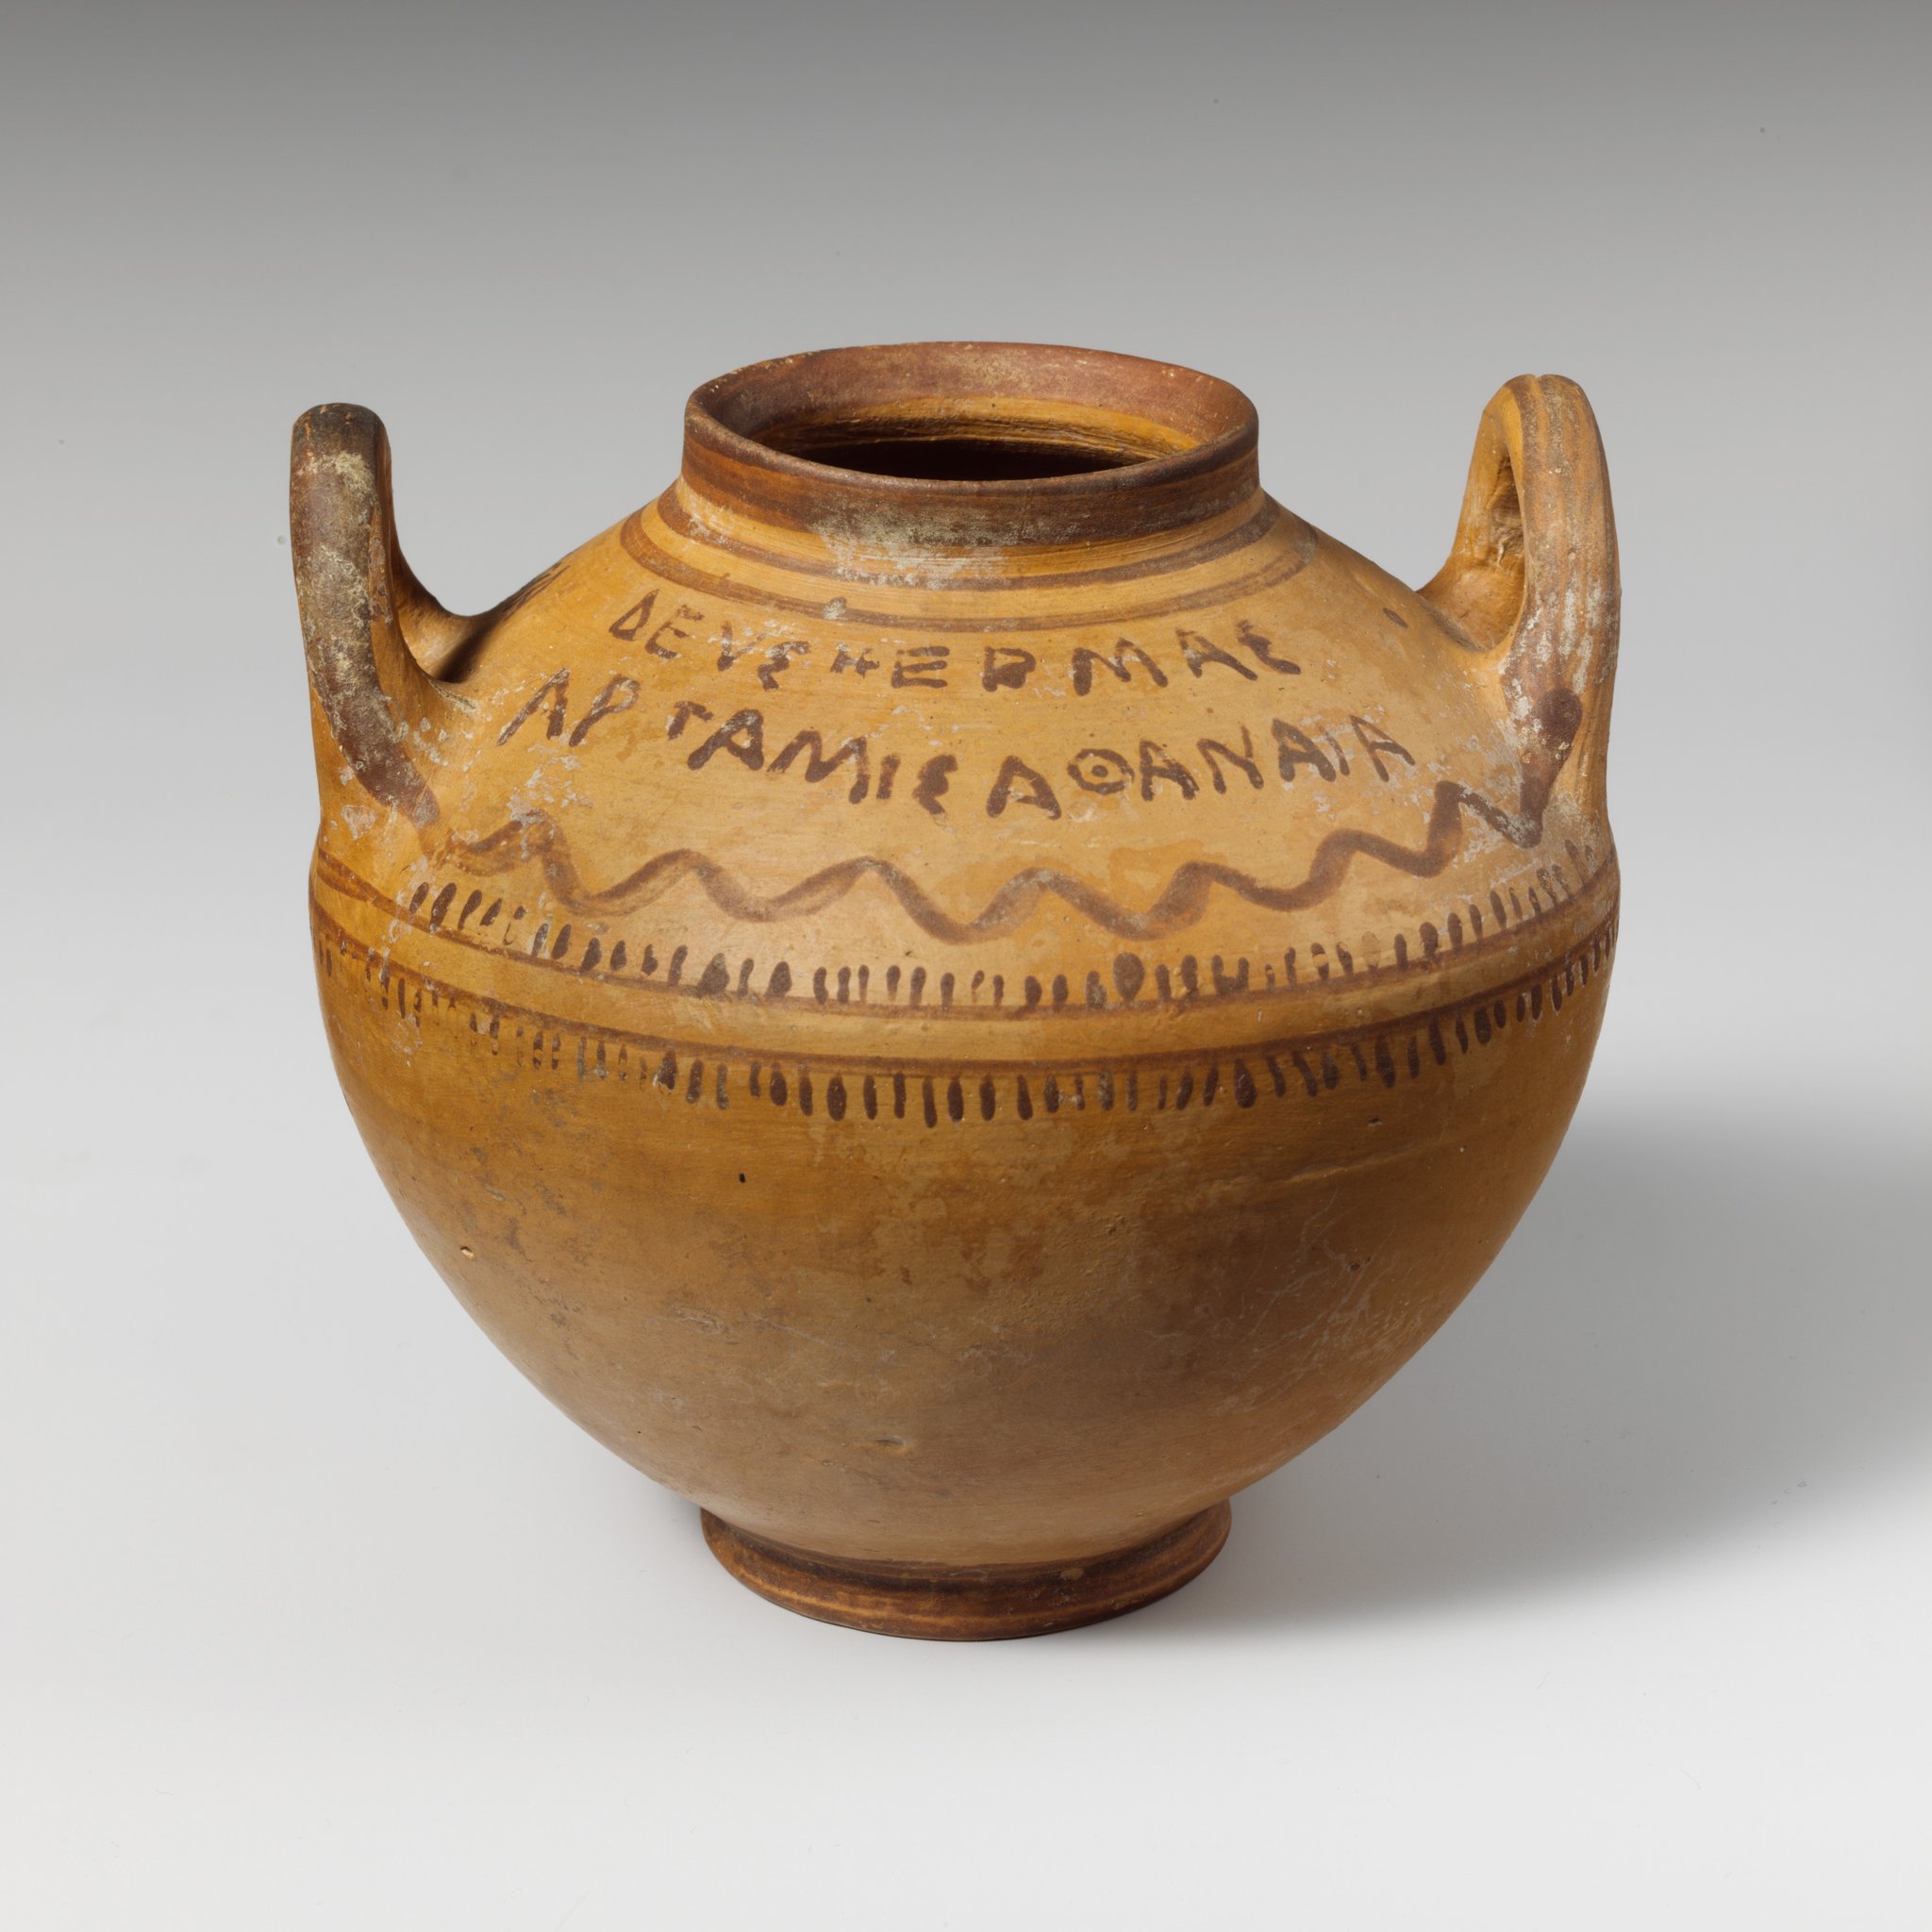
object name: pyxis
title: Terracotta pyxis (cosmetic box)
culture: east greek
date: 500-451 BCE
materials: terracotta